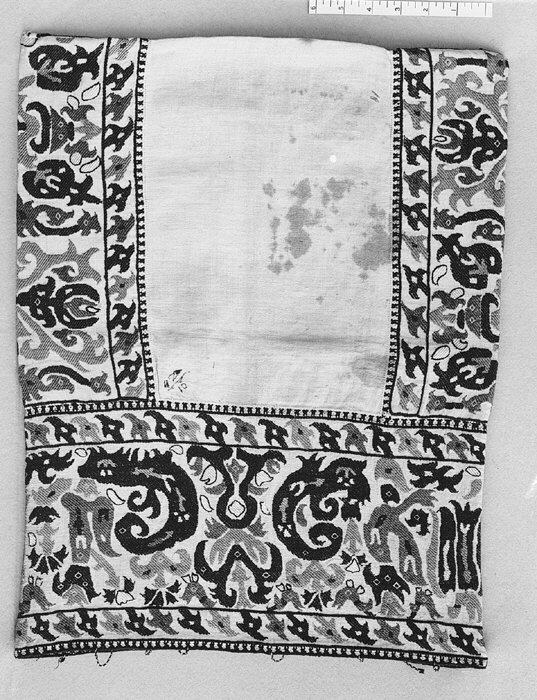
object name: pillowcase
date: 1701-1800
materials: linen, silk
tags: birds